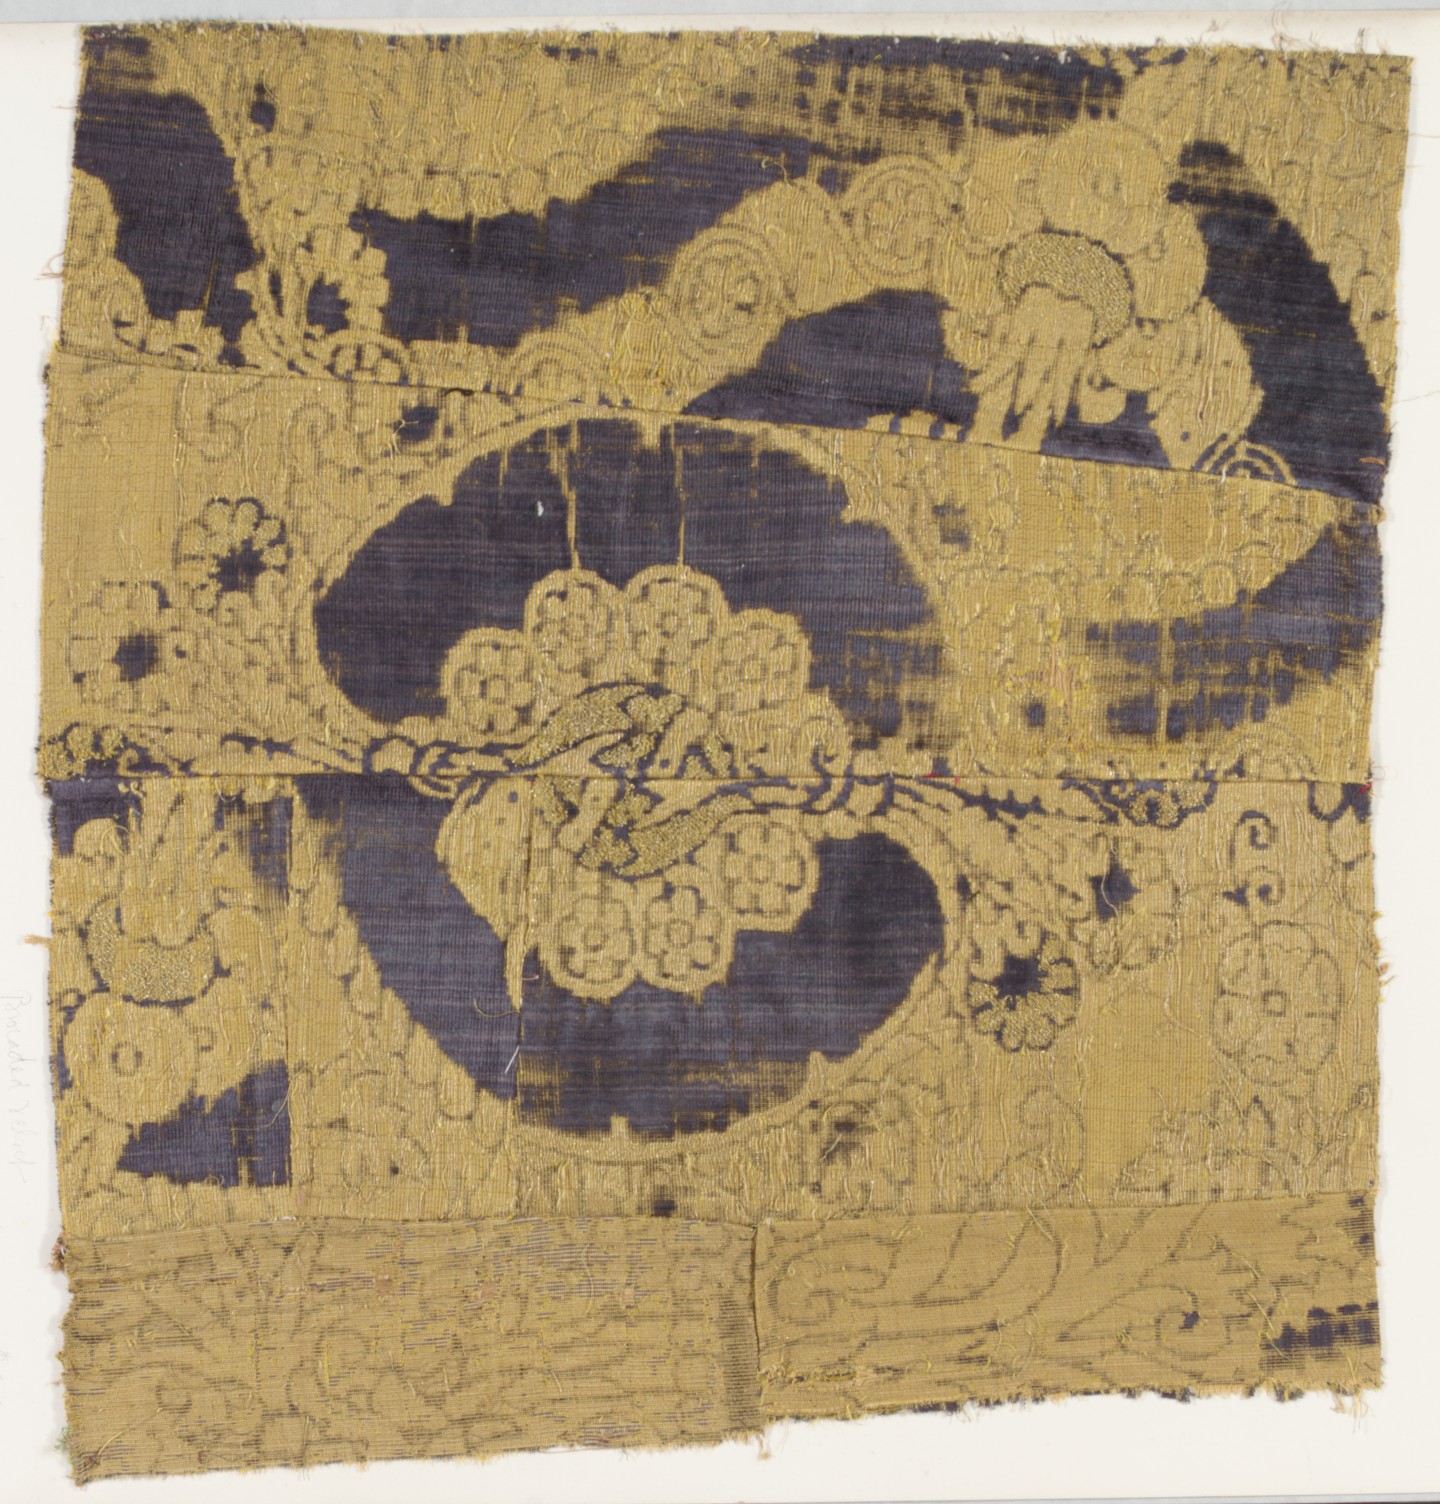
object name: fragment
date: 1401-1600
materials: metal thread, silk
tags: flowers